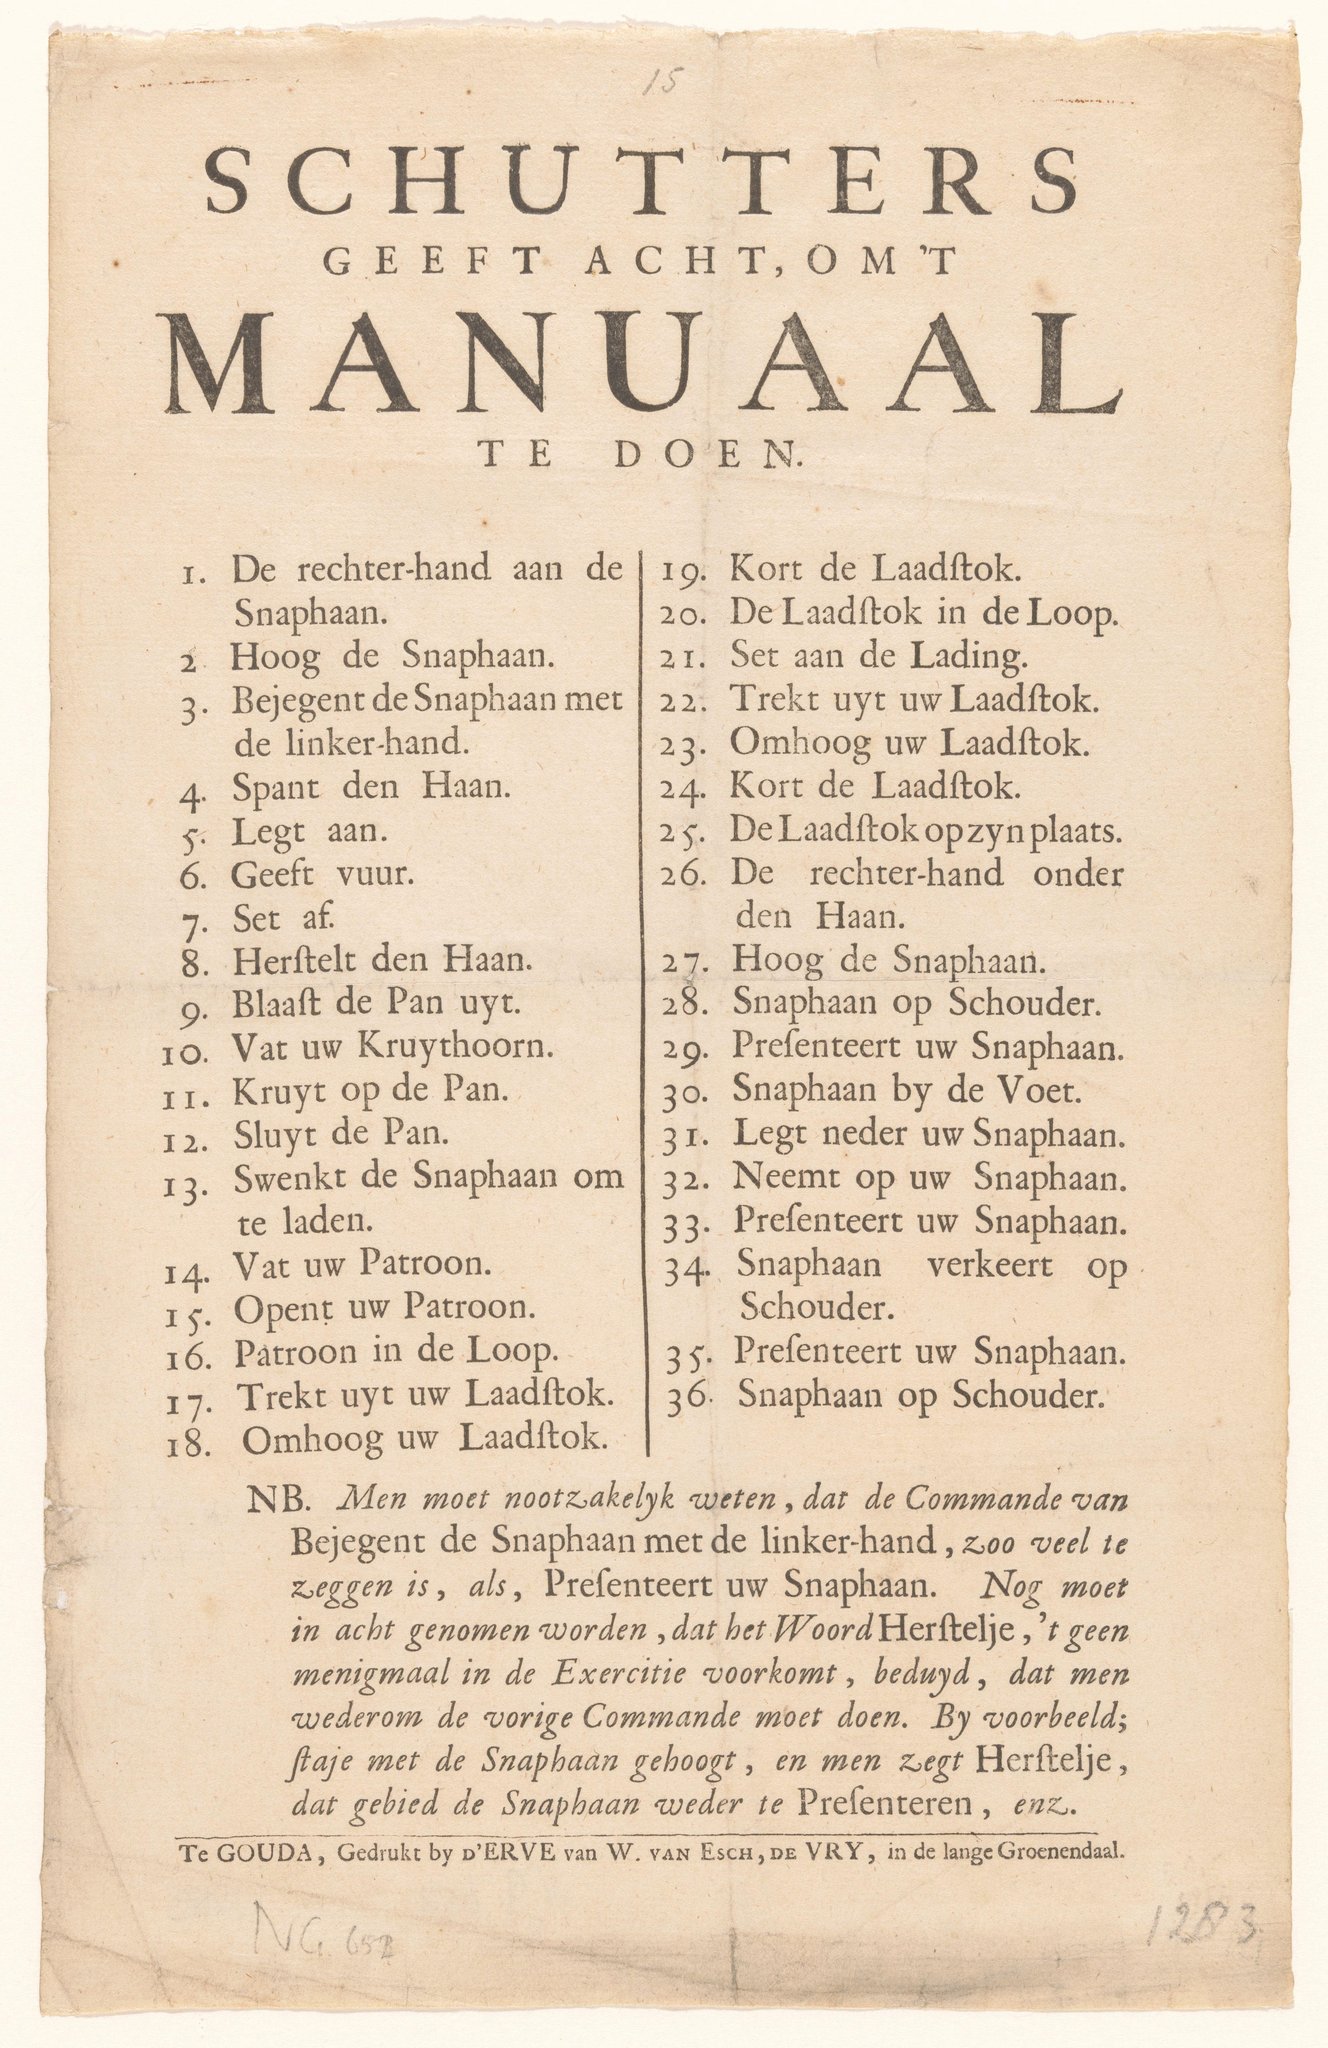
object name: manual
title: Schuttershandleiding voor het hanteren van een geweer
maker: willem van esch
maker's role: publisher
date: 1700-1800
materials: ink, paper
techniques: printing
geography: gouda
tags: gouda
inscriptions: inscription: ‘SCHUTTERS / GEEFT ACHT, OM 'T / MANUAAL / TE DOEN’